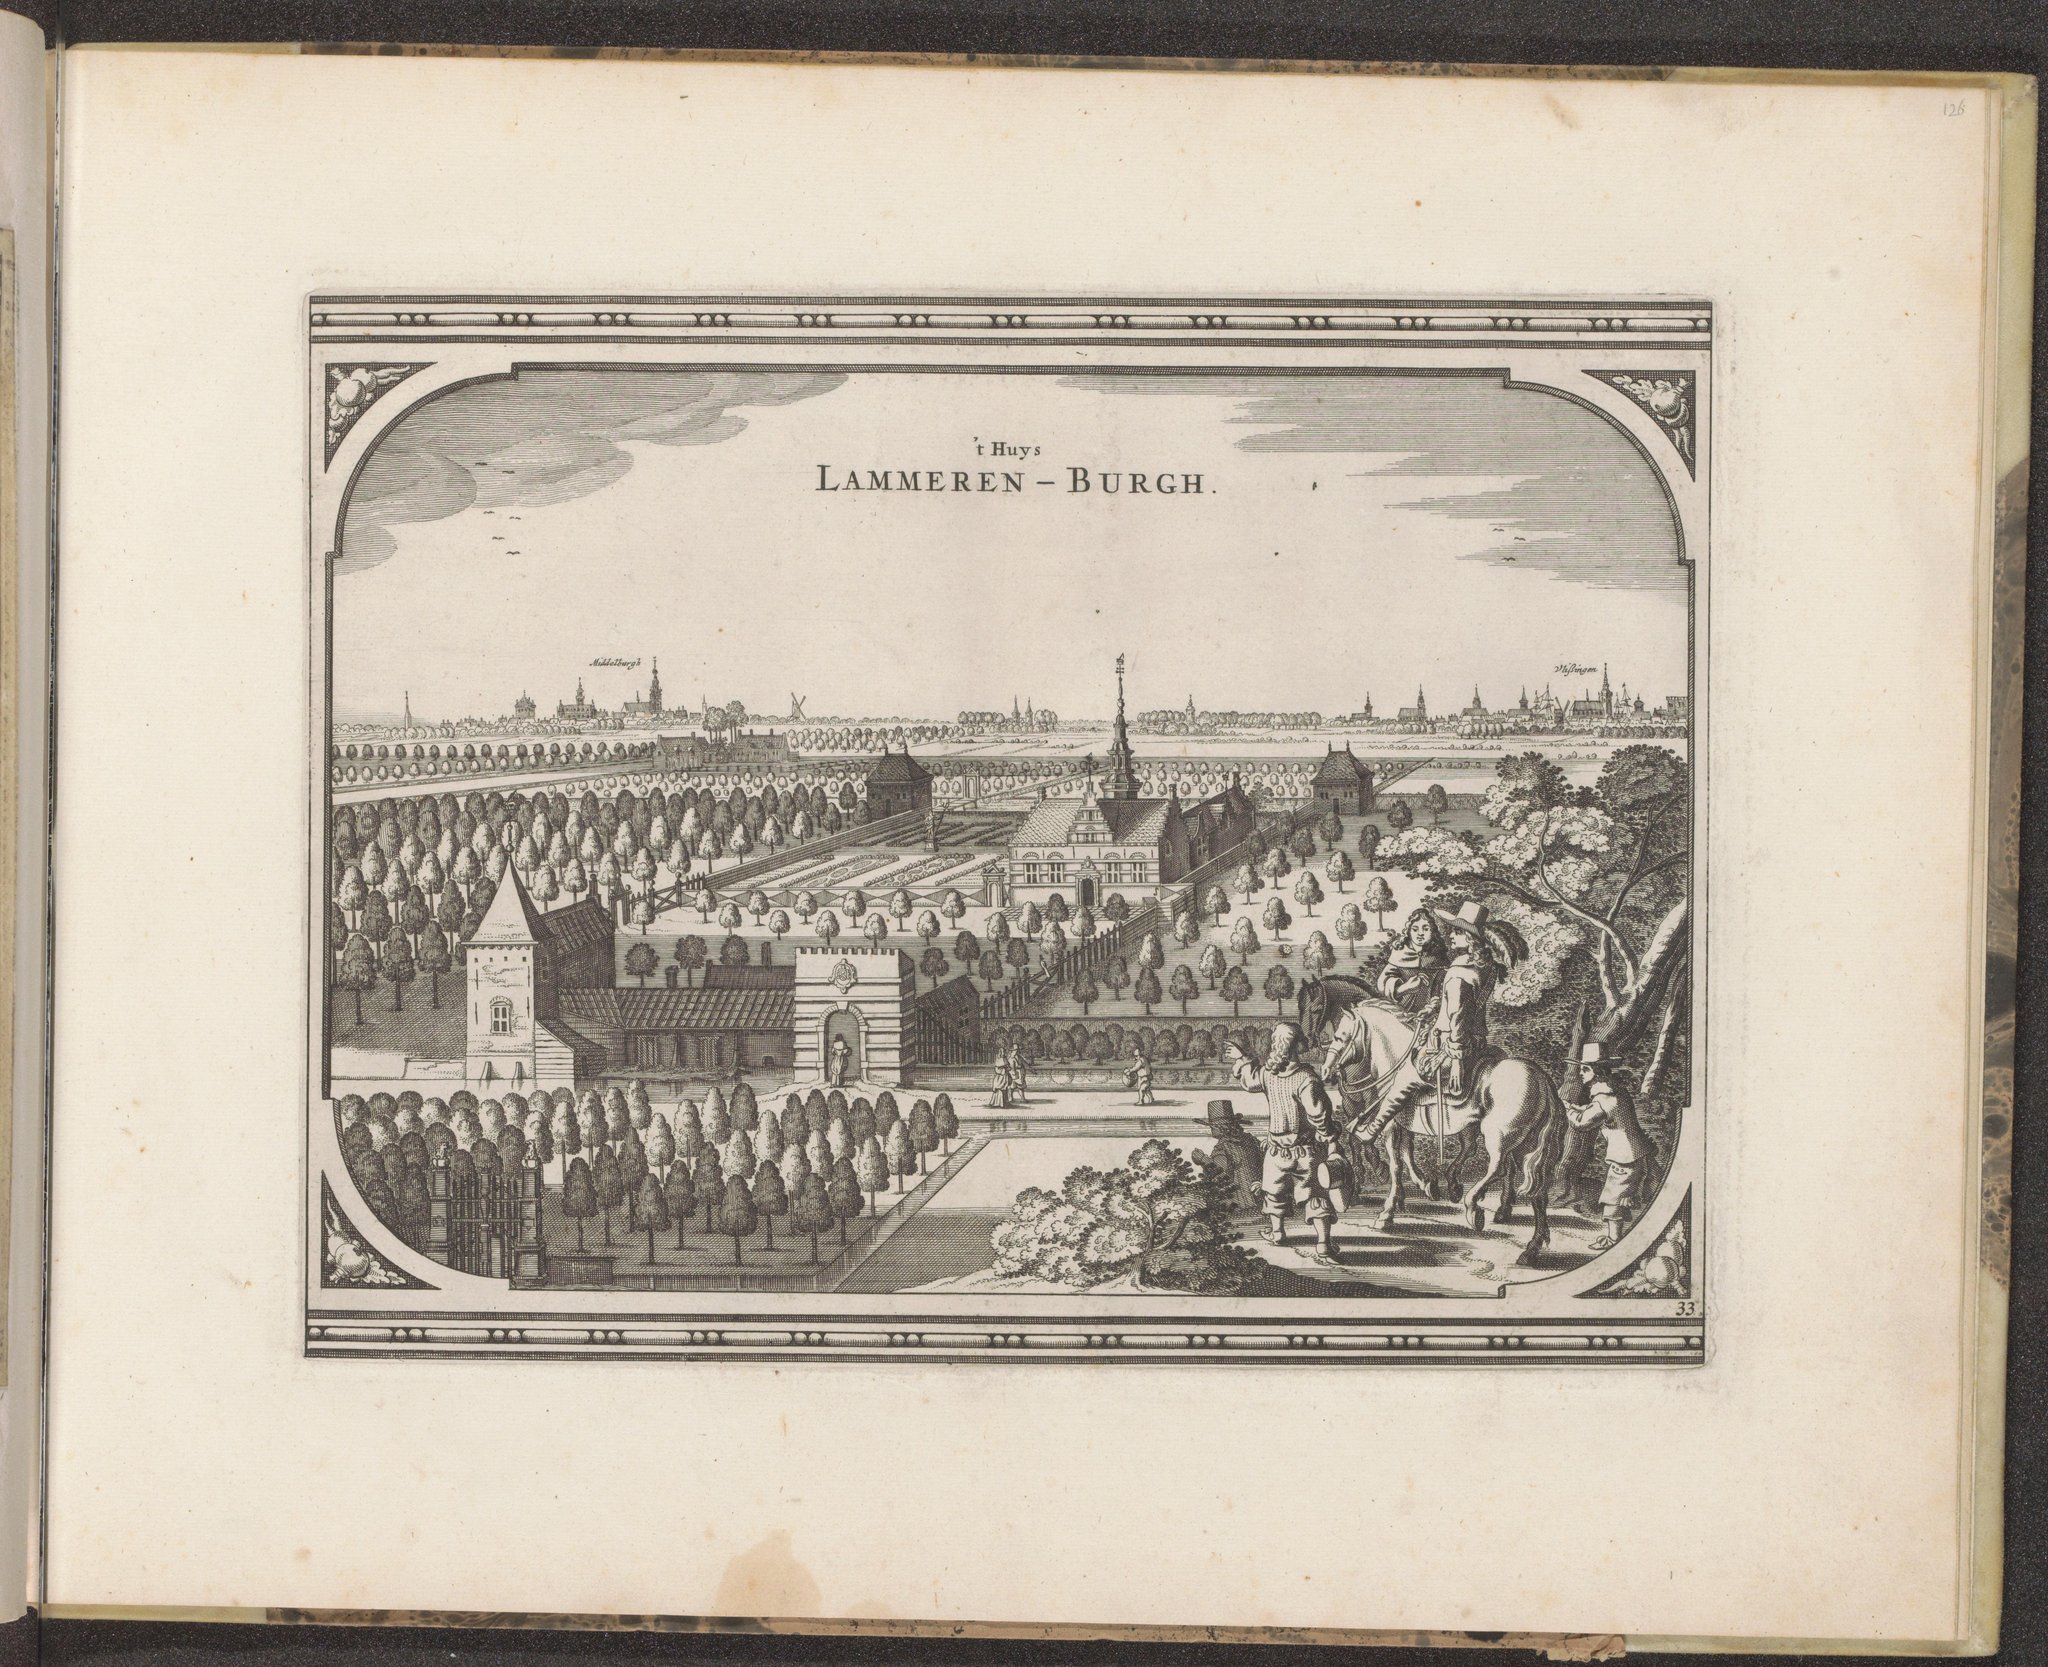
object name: album leaf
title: Speculum Zelandiae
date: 1662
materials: paper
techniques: etching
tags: city-view, and landscape with man-made constructions, rural housing, e.g. country-house, villa, cottage, index finger forwards, pointing, indicating, middelburg, flushing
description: Gezicht op buitenplaats Lammerenburg. In de verte liggen de steden Middelburg en Vlissingen. Op de voorgrond rechts wordt een welgesteld paar te paard de weg naar de hofstede gewezen. De prent maakt deel uit van een album.